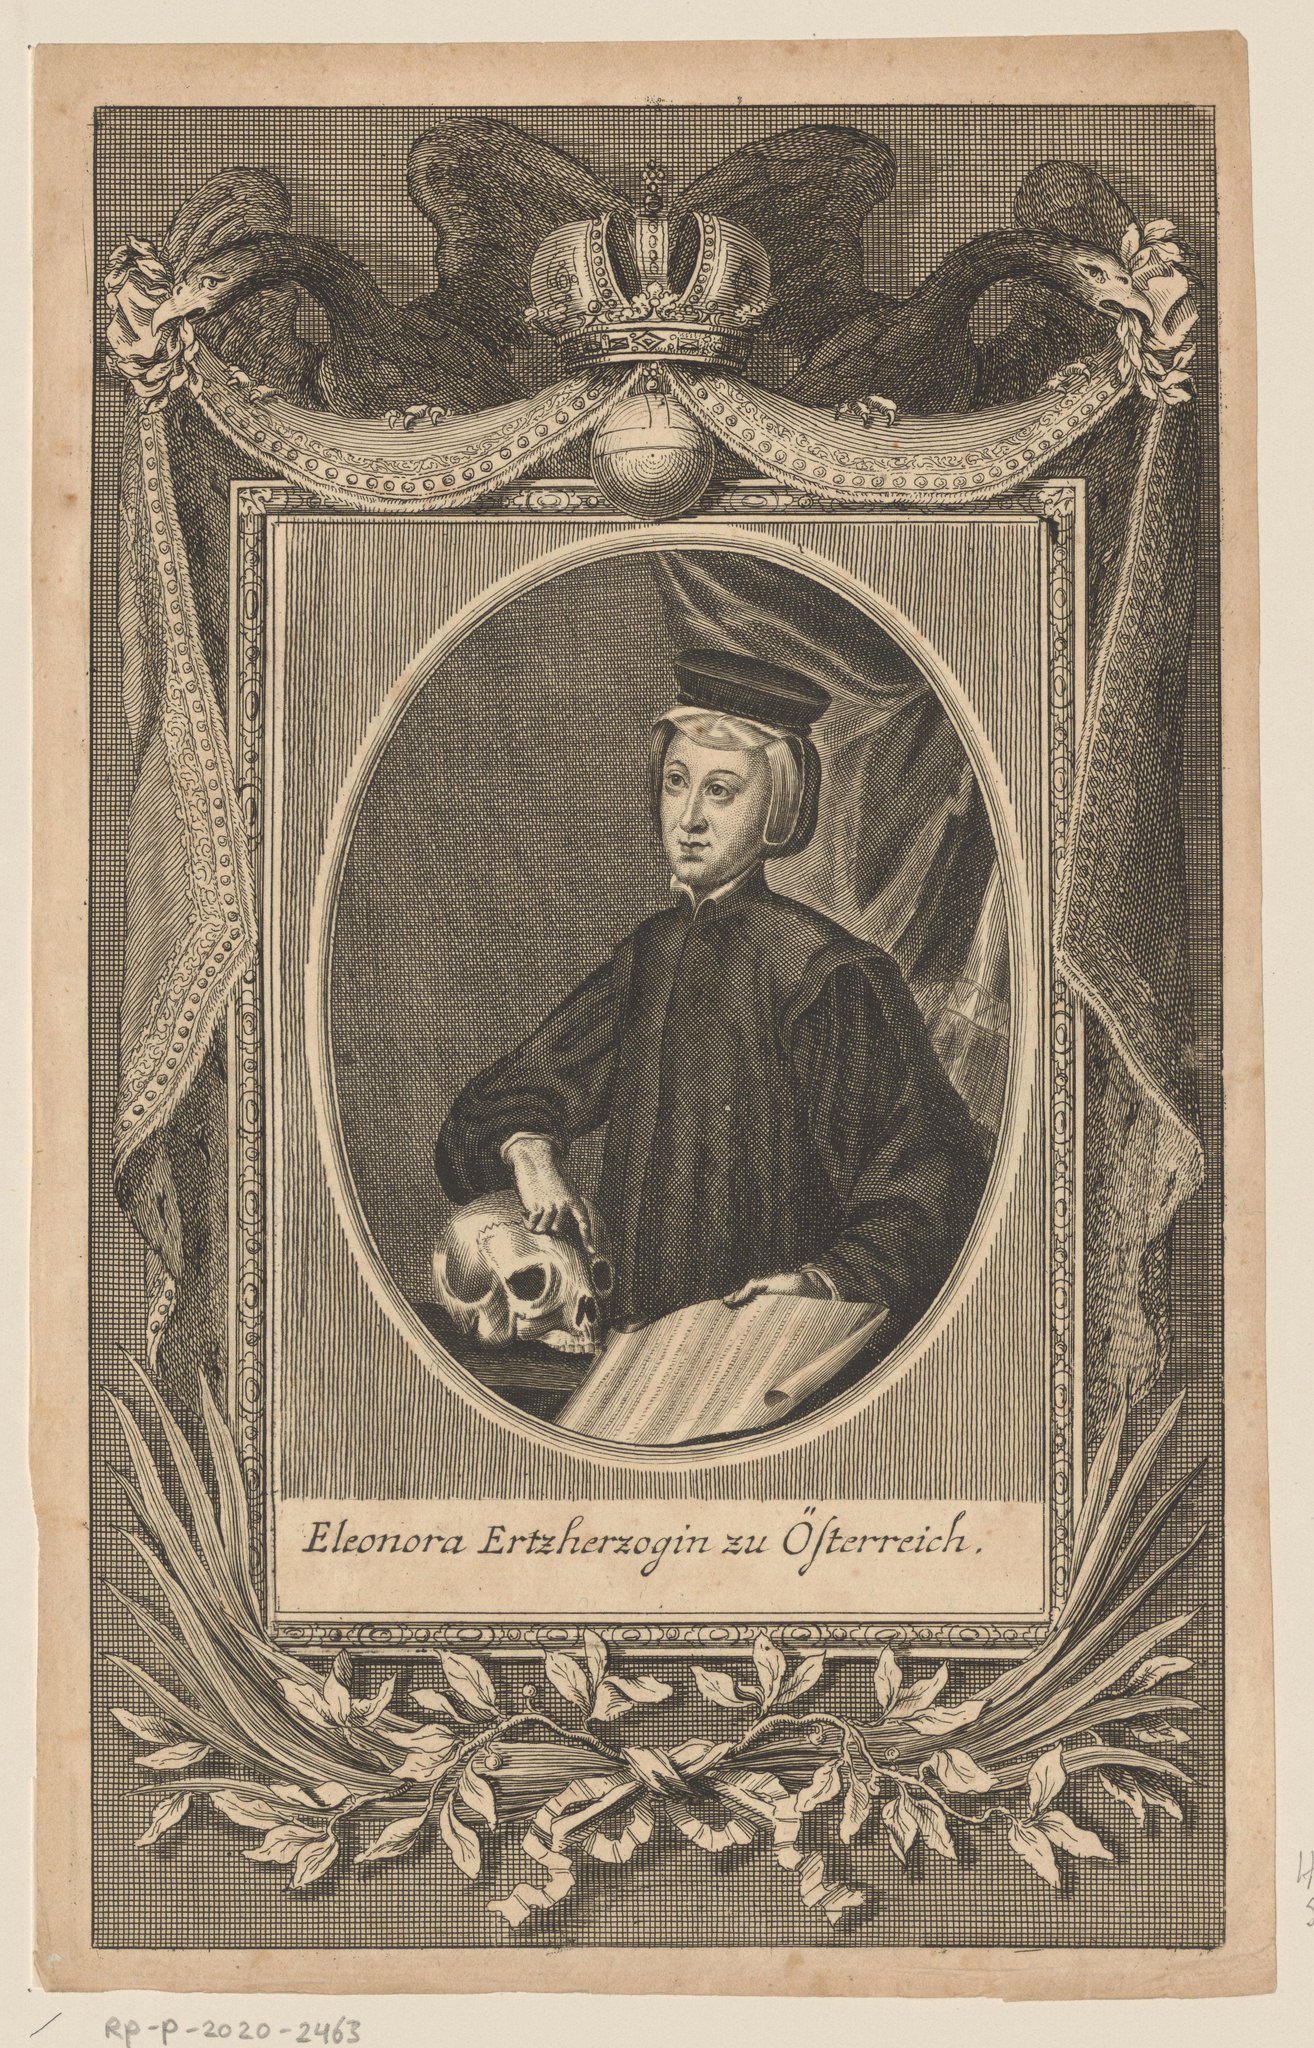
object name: book illustration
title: Portret van Eleonora van Oostenrijk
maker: Anonymous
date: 1721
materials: paper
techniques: engraving, etching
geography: germany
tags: (human) skull, historical persons - bb - woman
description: Prent waarschijnlijk uit: Khevenhüller, Franz Christoph. Conterfet Kupfferstich (...). Leipzig: Moritz Georg Weidmann, 1721.